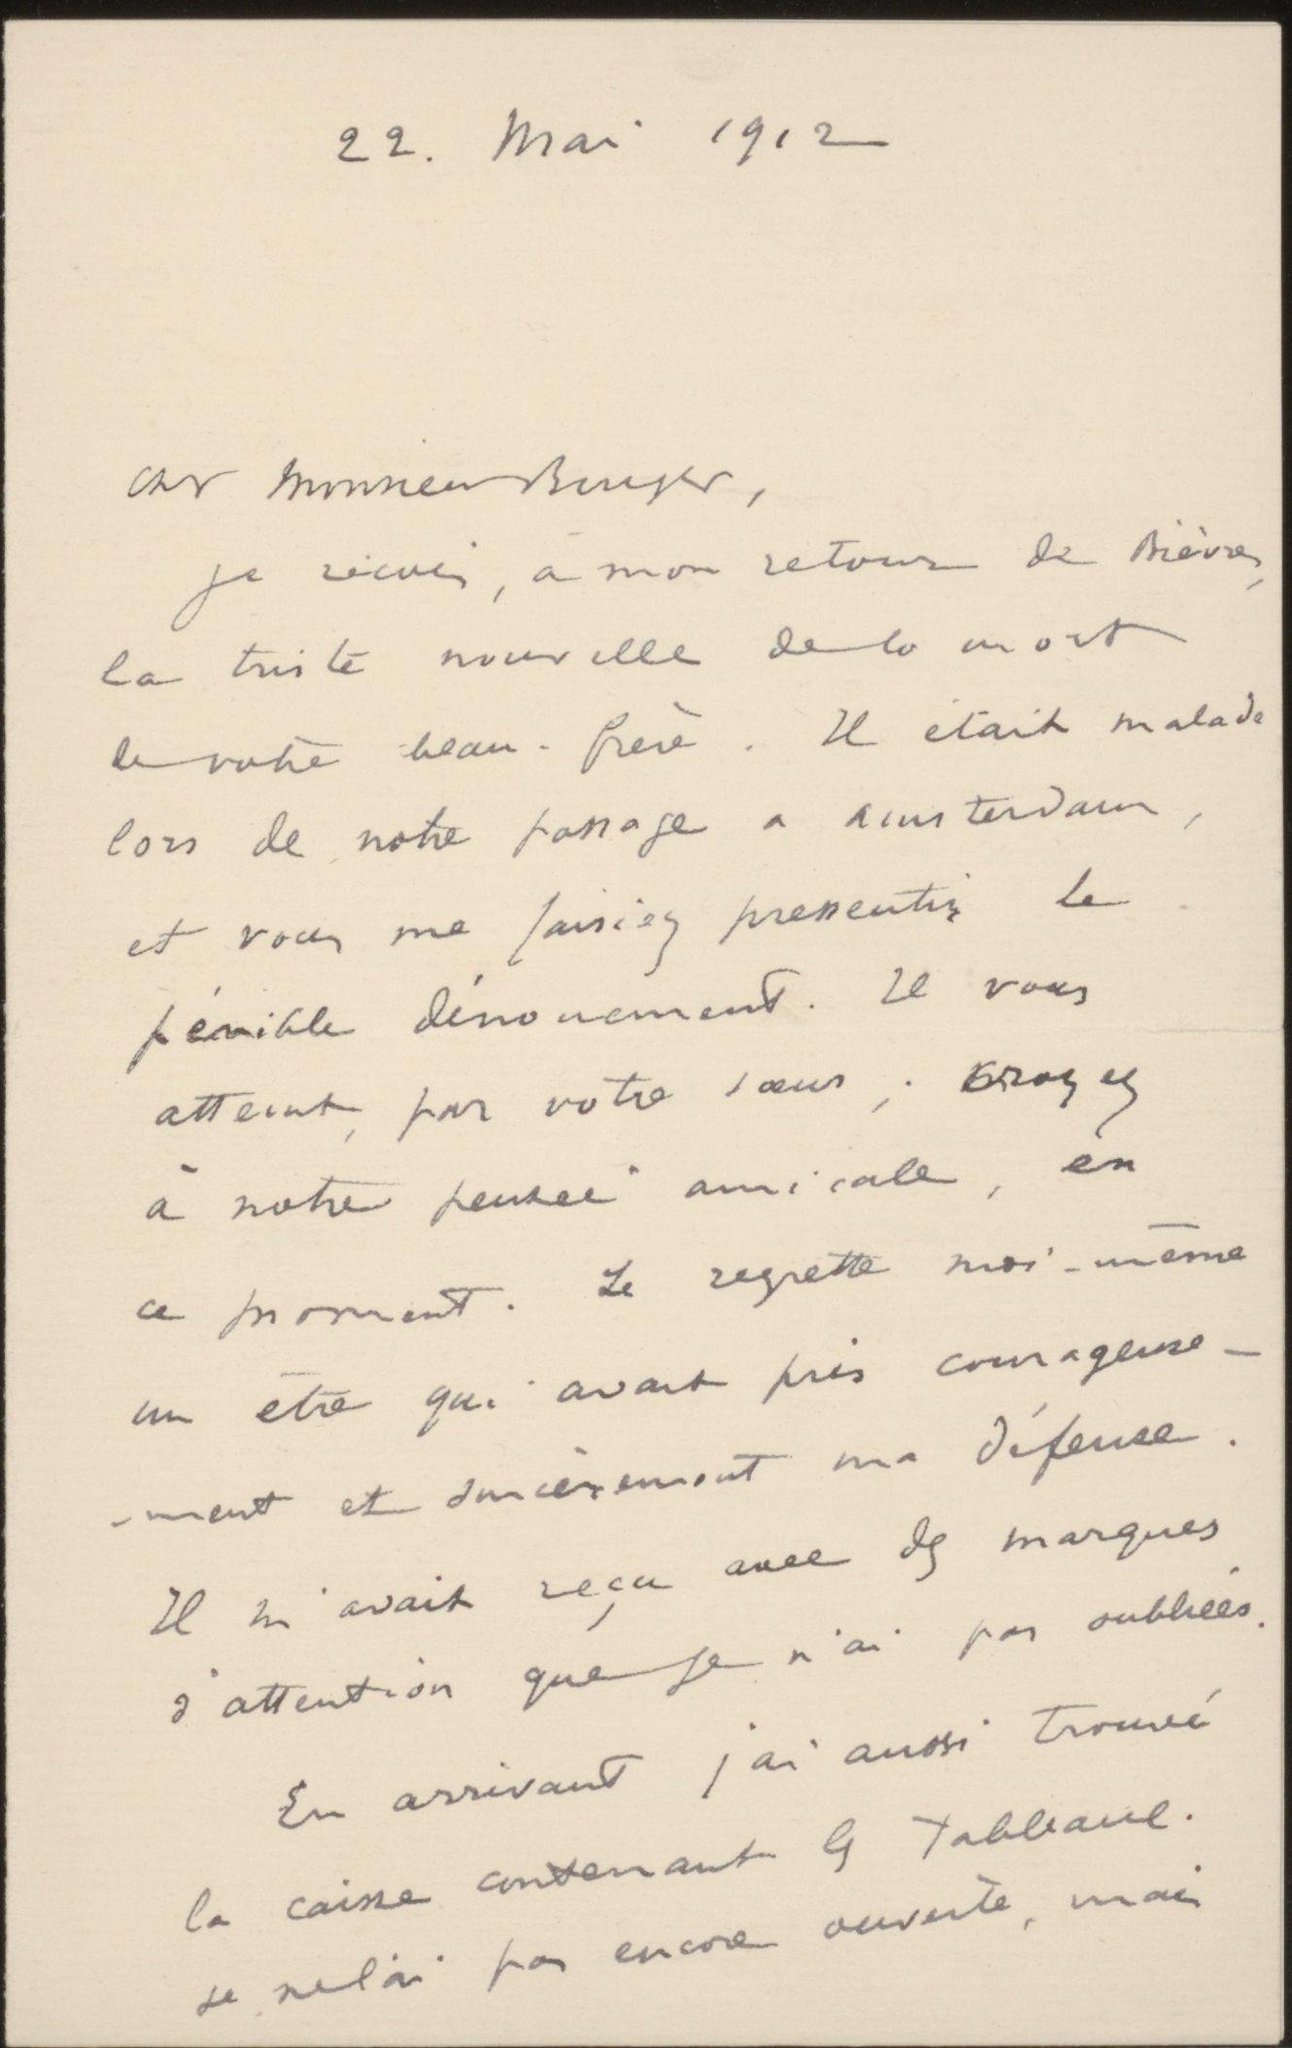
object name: letter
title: Brief aan Andries Bonger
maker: odilon redon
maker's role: draughtsman, painter, print maker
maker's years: 1840-1916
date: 1912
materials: ink, paper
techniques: pen, writing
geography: paris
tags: paris, print maker, draughtsman, eugène delacroix, amsterdam, andries bonger, drawing, family life, painting (including book-illumination, miniature-painting), exhibition ~ art, money, cologne